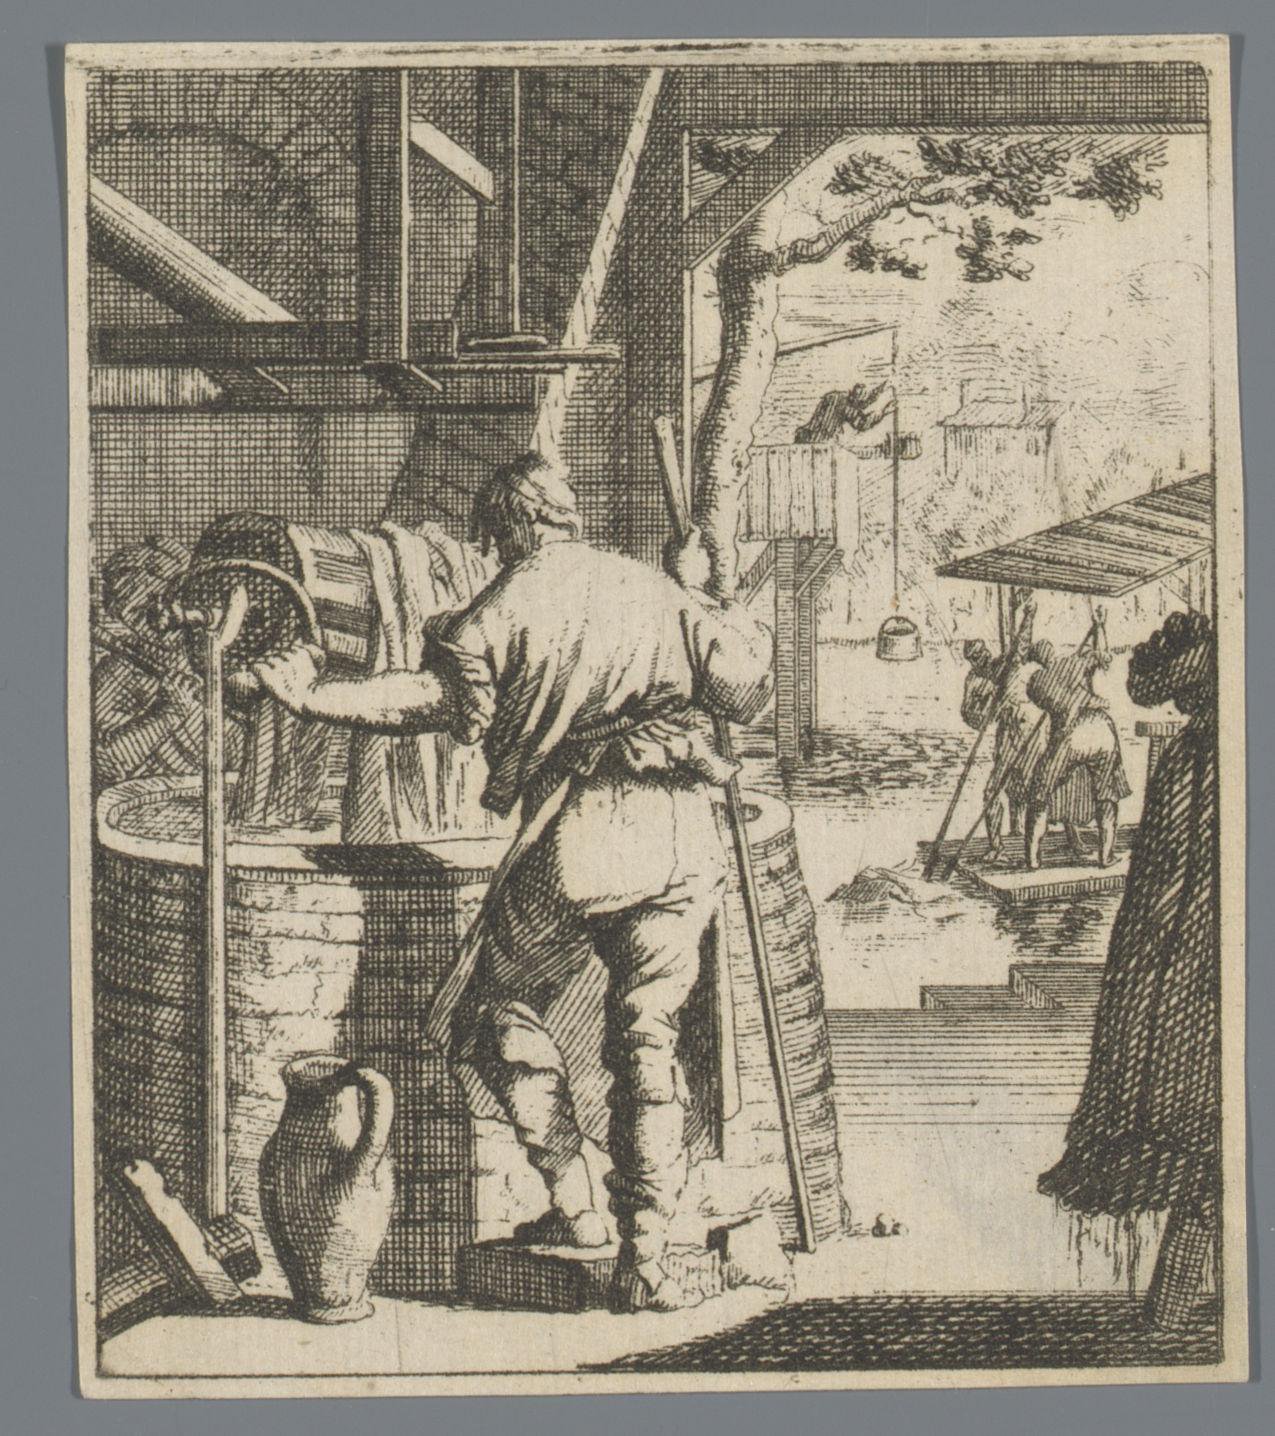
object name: print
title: Een wasserij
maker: jan luyken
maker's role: draughtsman, print maker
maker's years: 1649-1712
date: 1659-1712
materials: paper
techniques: etching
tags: bleaching (laundering)